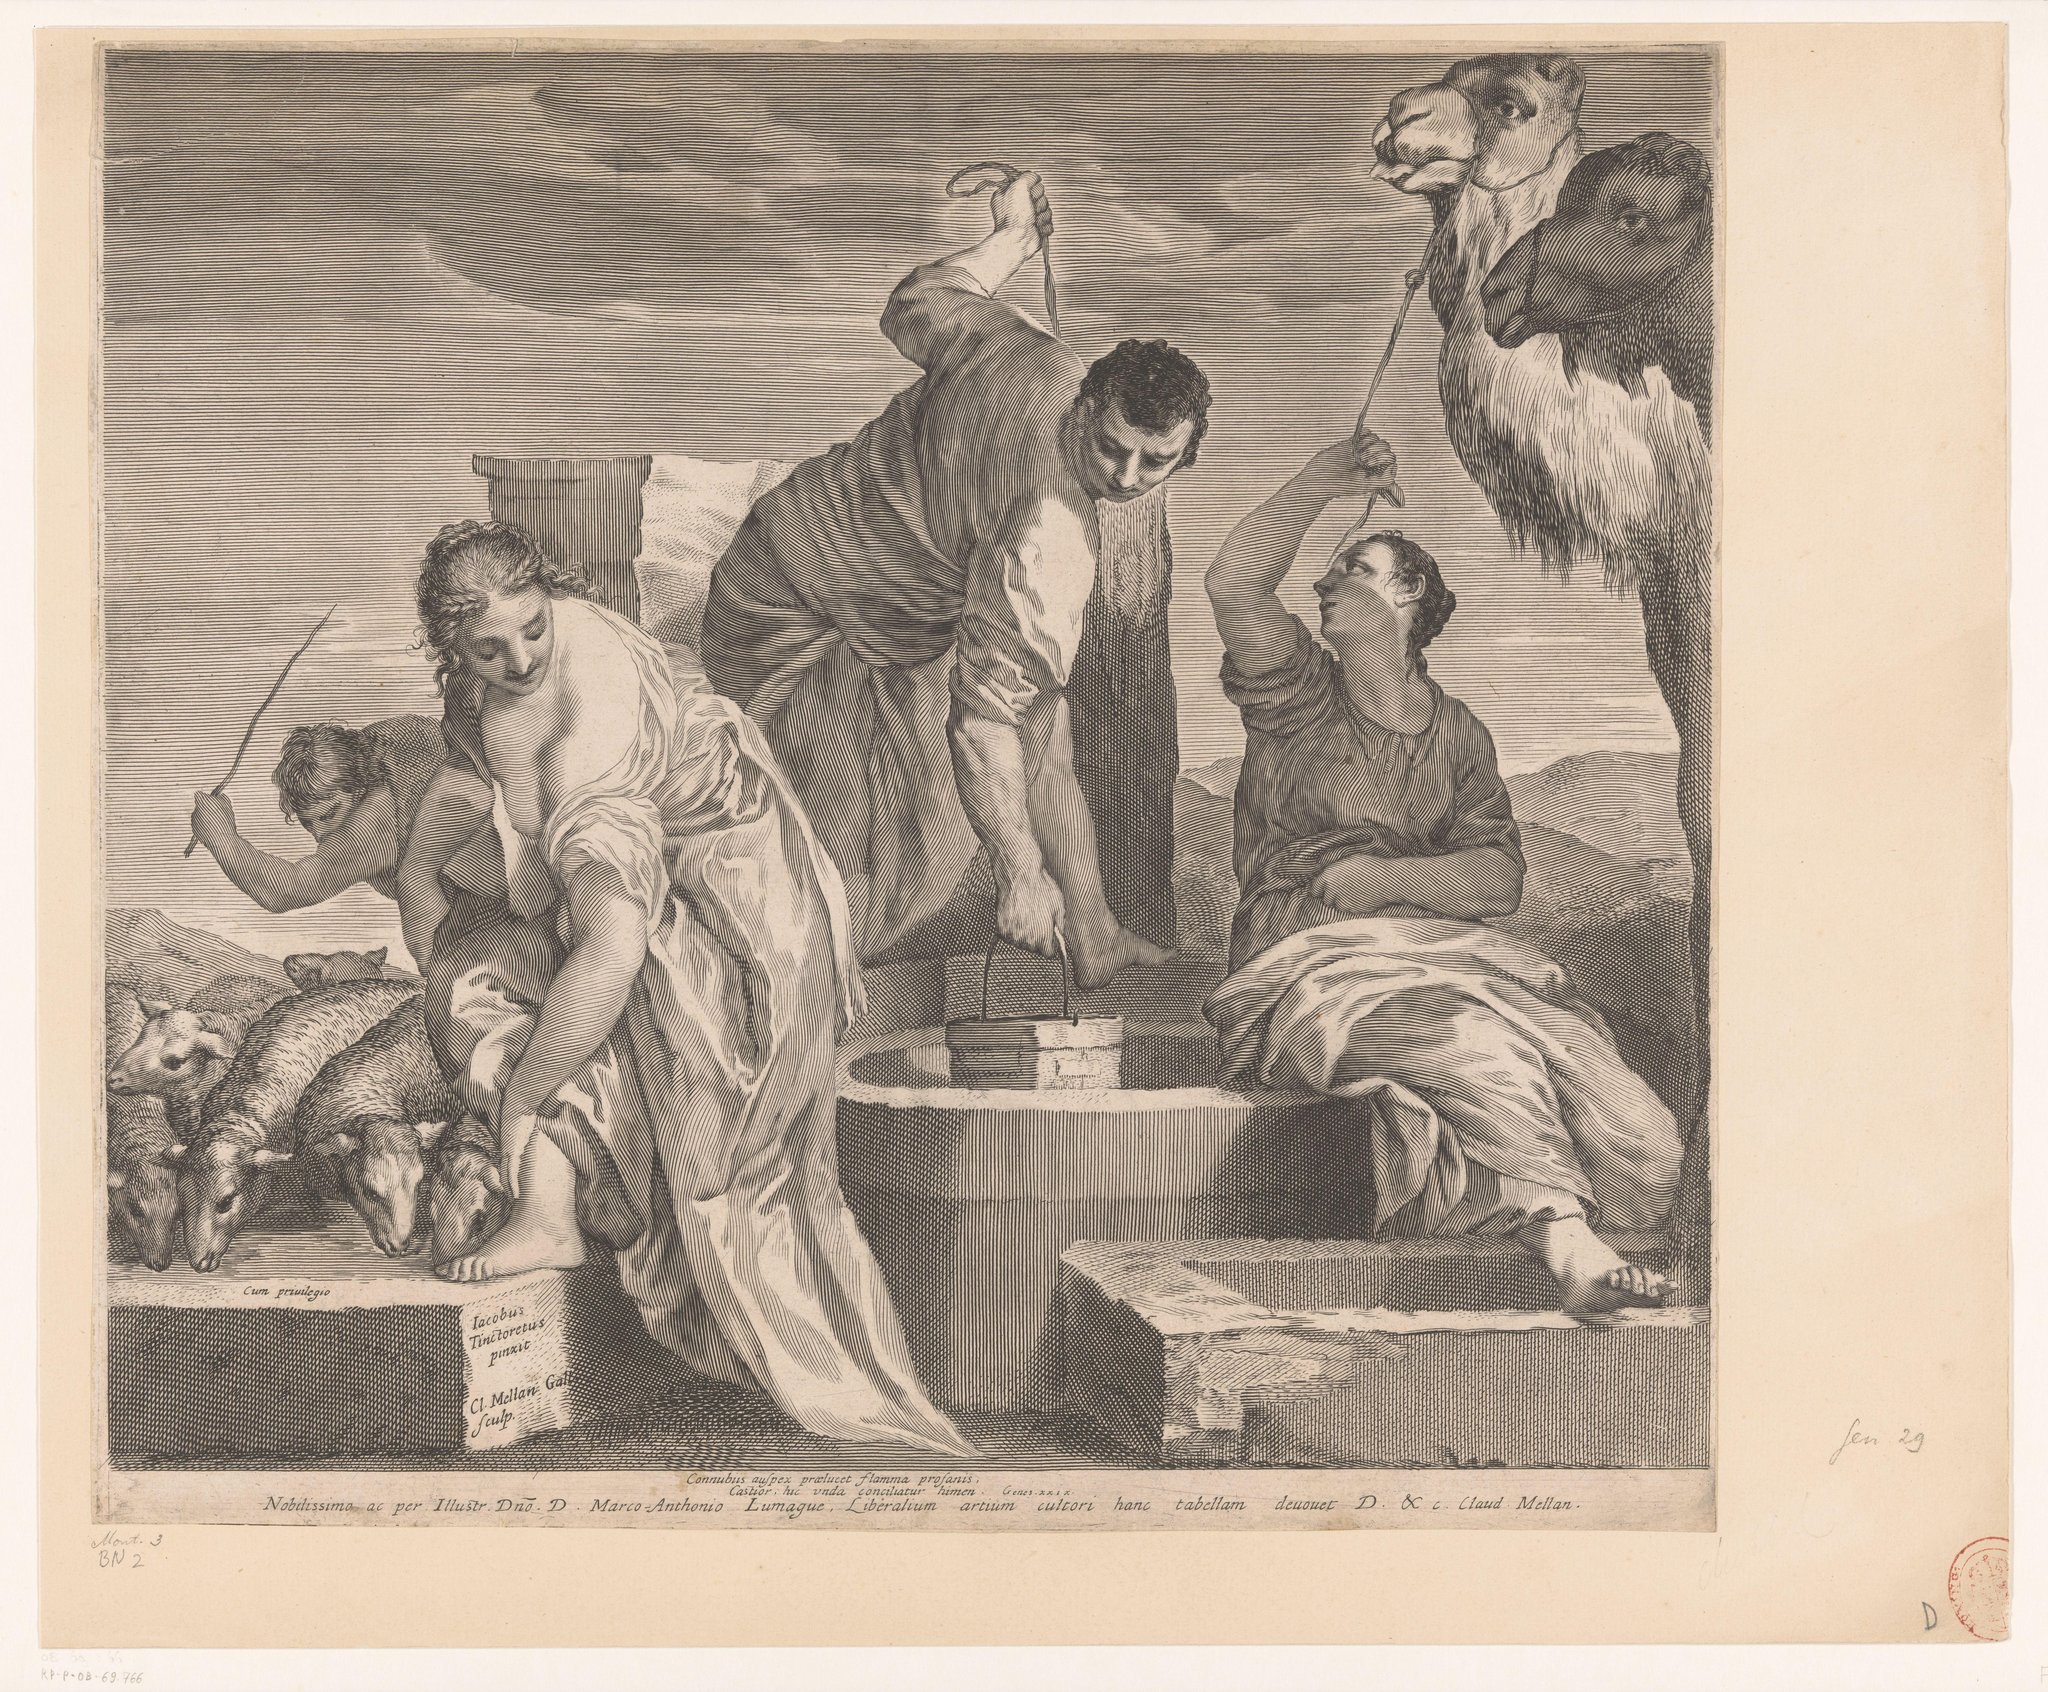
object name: print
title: Jakob geeft de kudde van Rachel te drinken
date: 1608-1688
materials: paper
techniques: engraving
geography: france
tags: jacob moves the stone which covers the opening of the well and waters rachel's sheep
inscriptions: collector's mark: Lugt 240